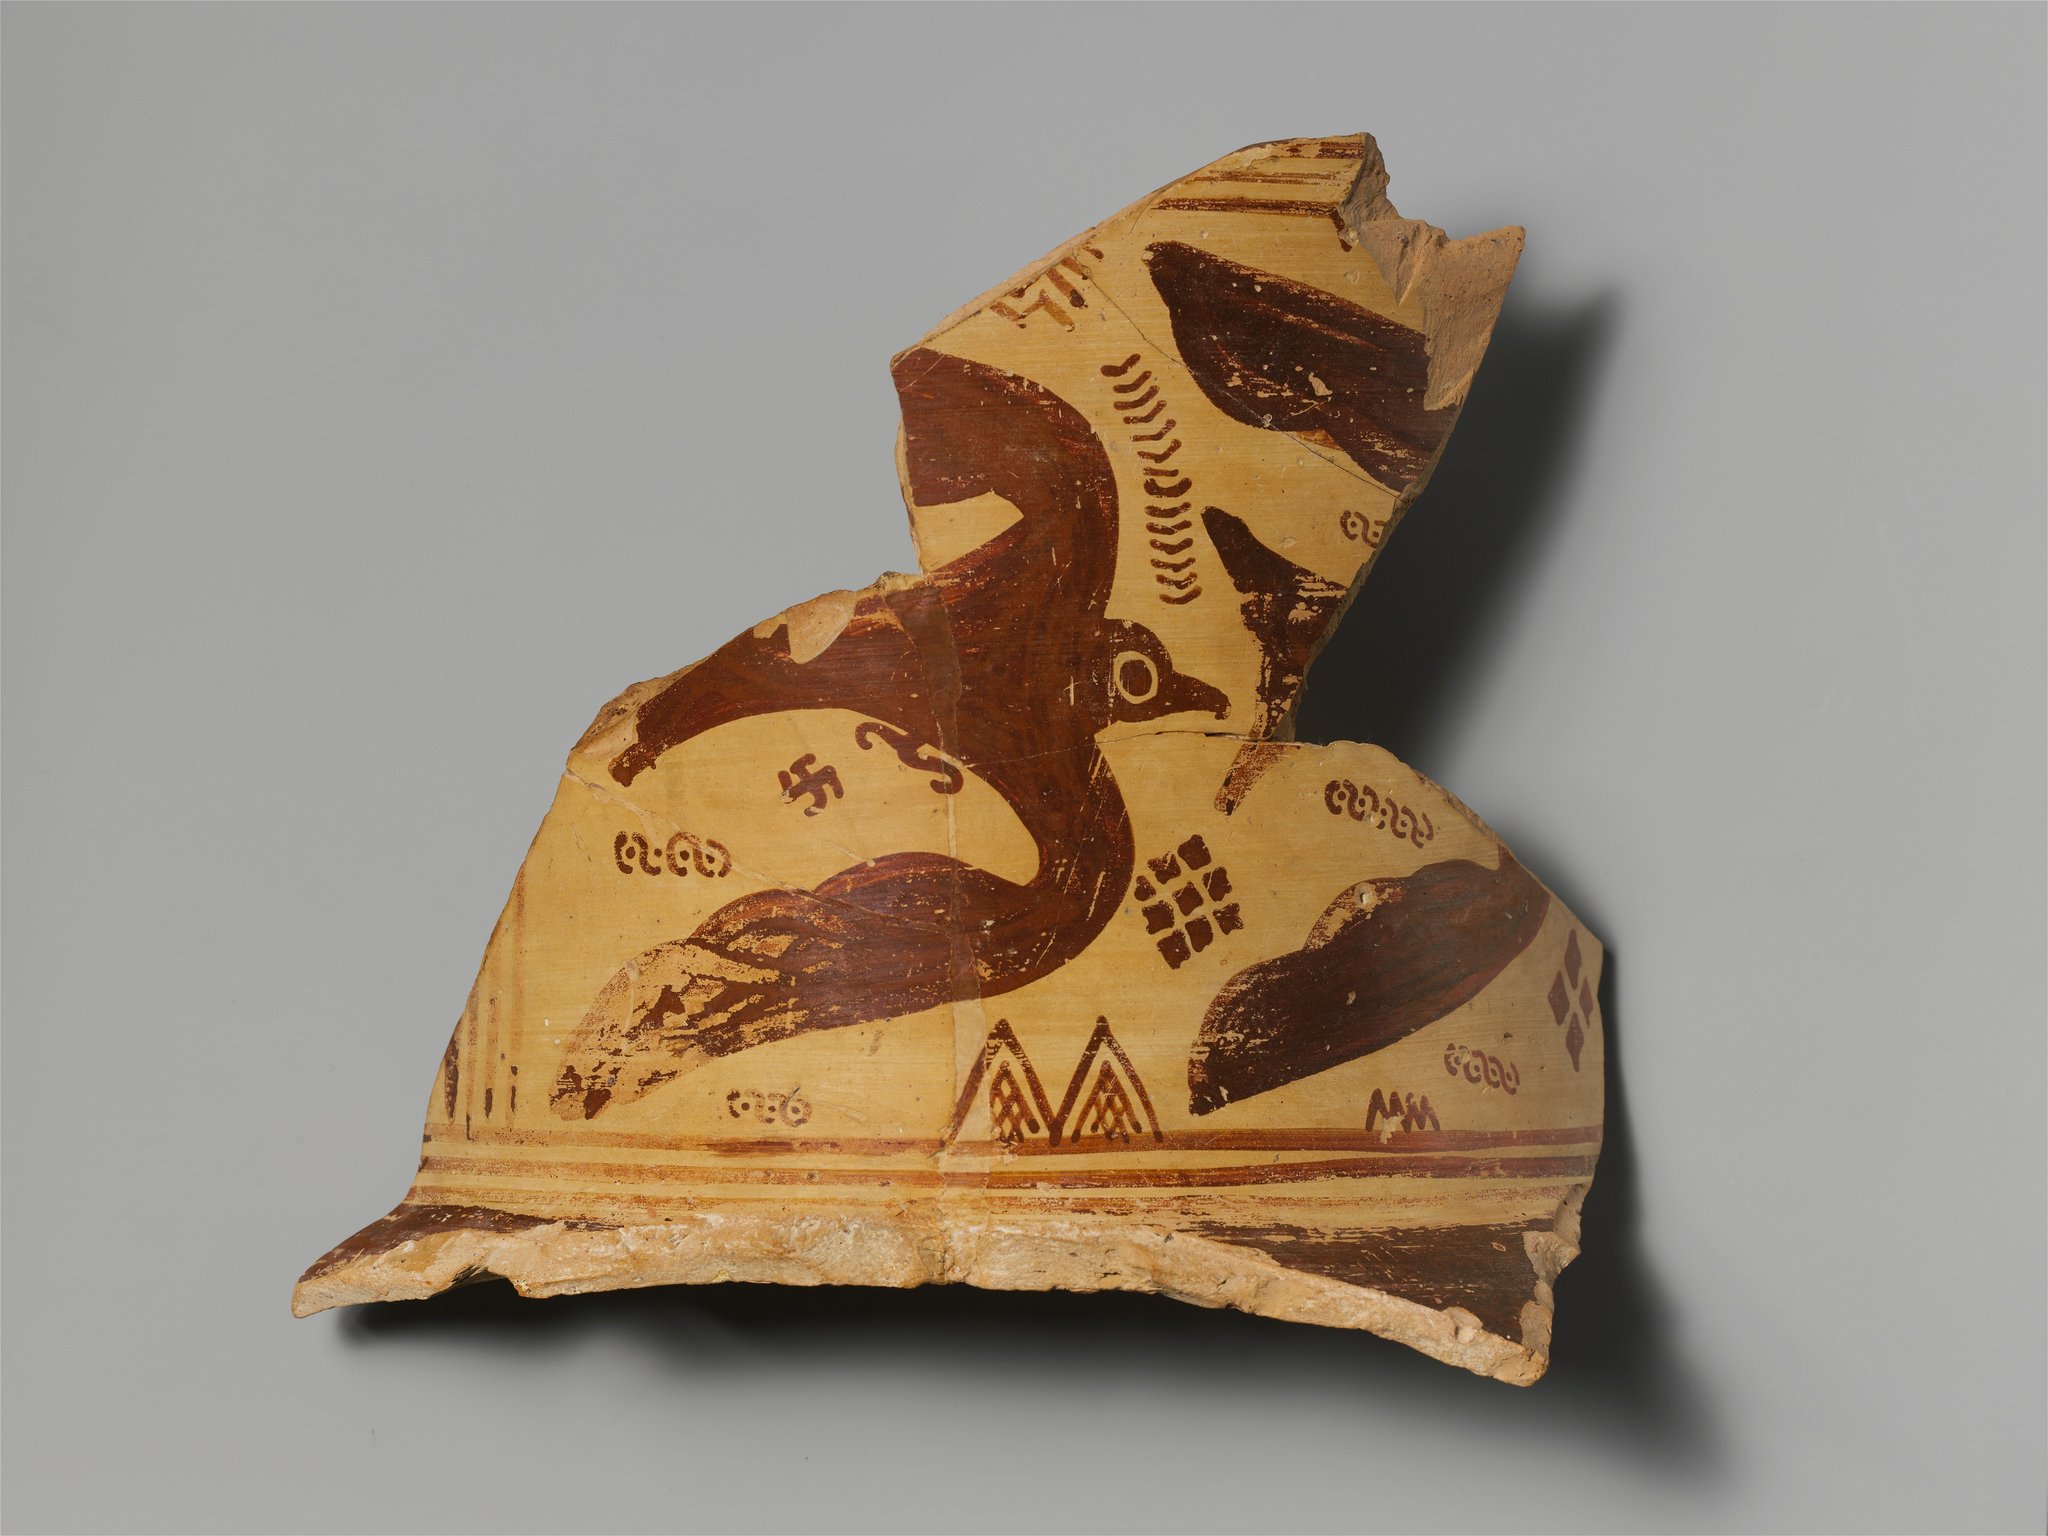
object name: neck amphora, fragmentary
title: Fragmentary neck-amphora (jar)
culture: greek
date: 675 BCE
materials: terracotta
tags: eagles